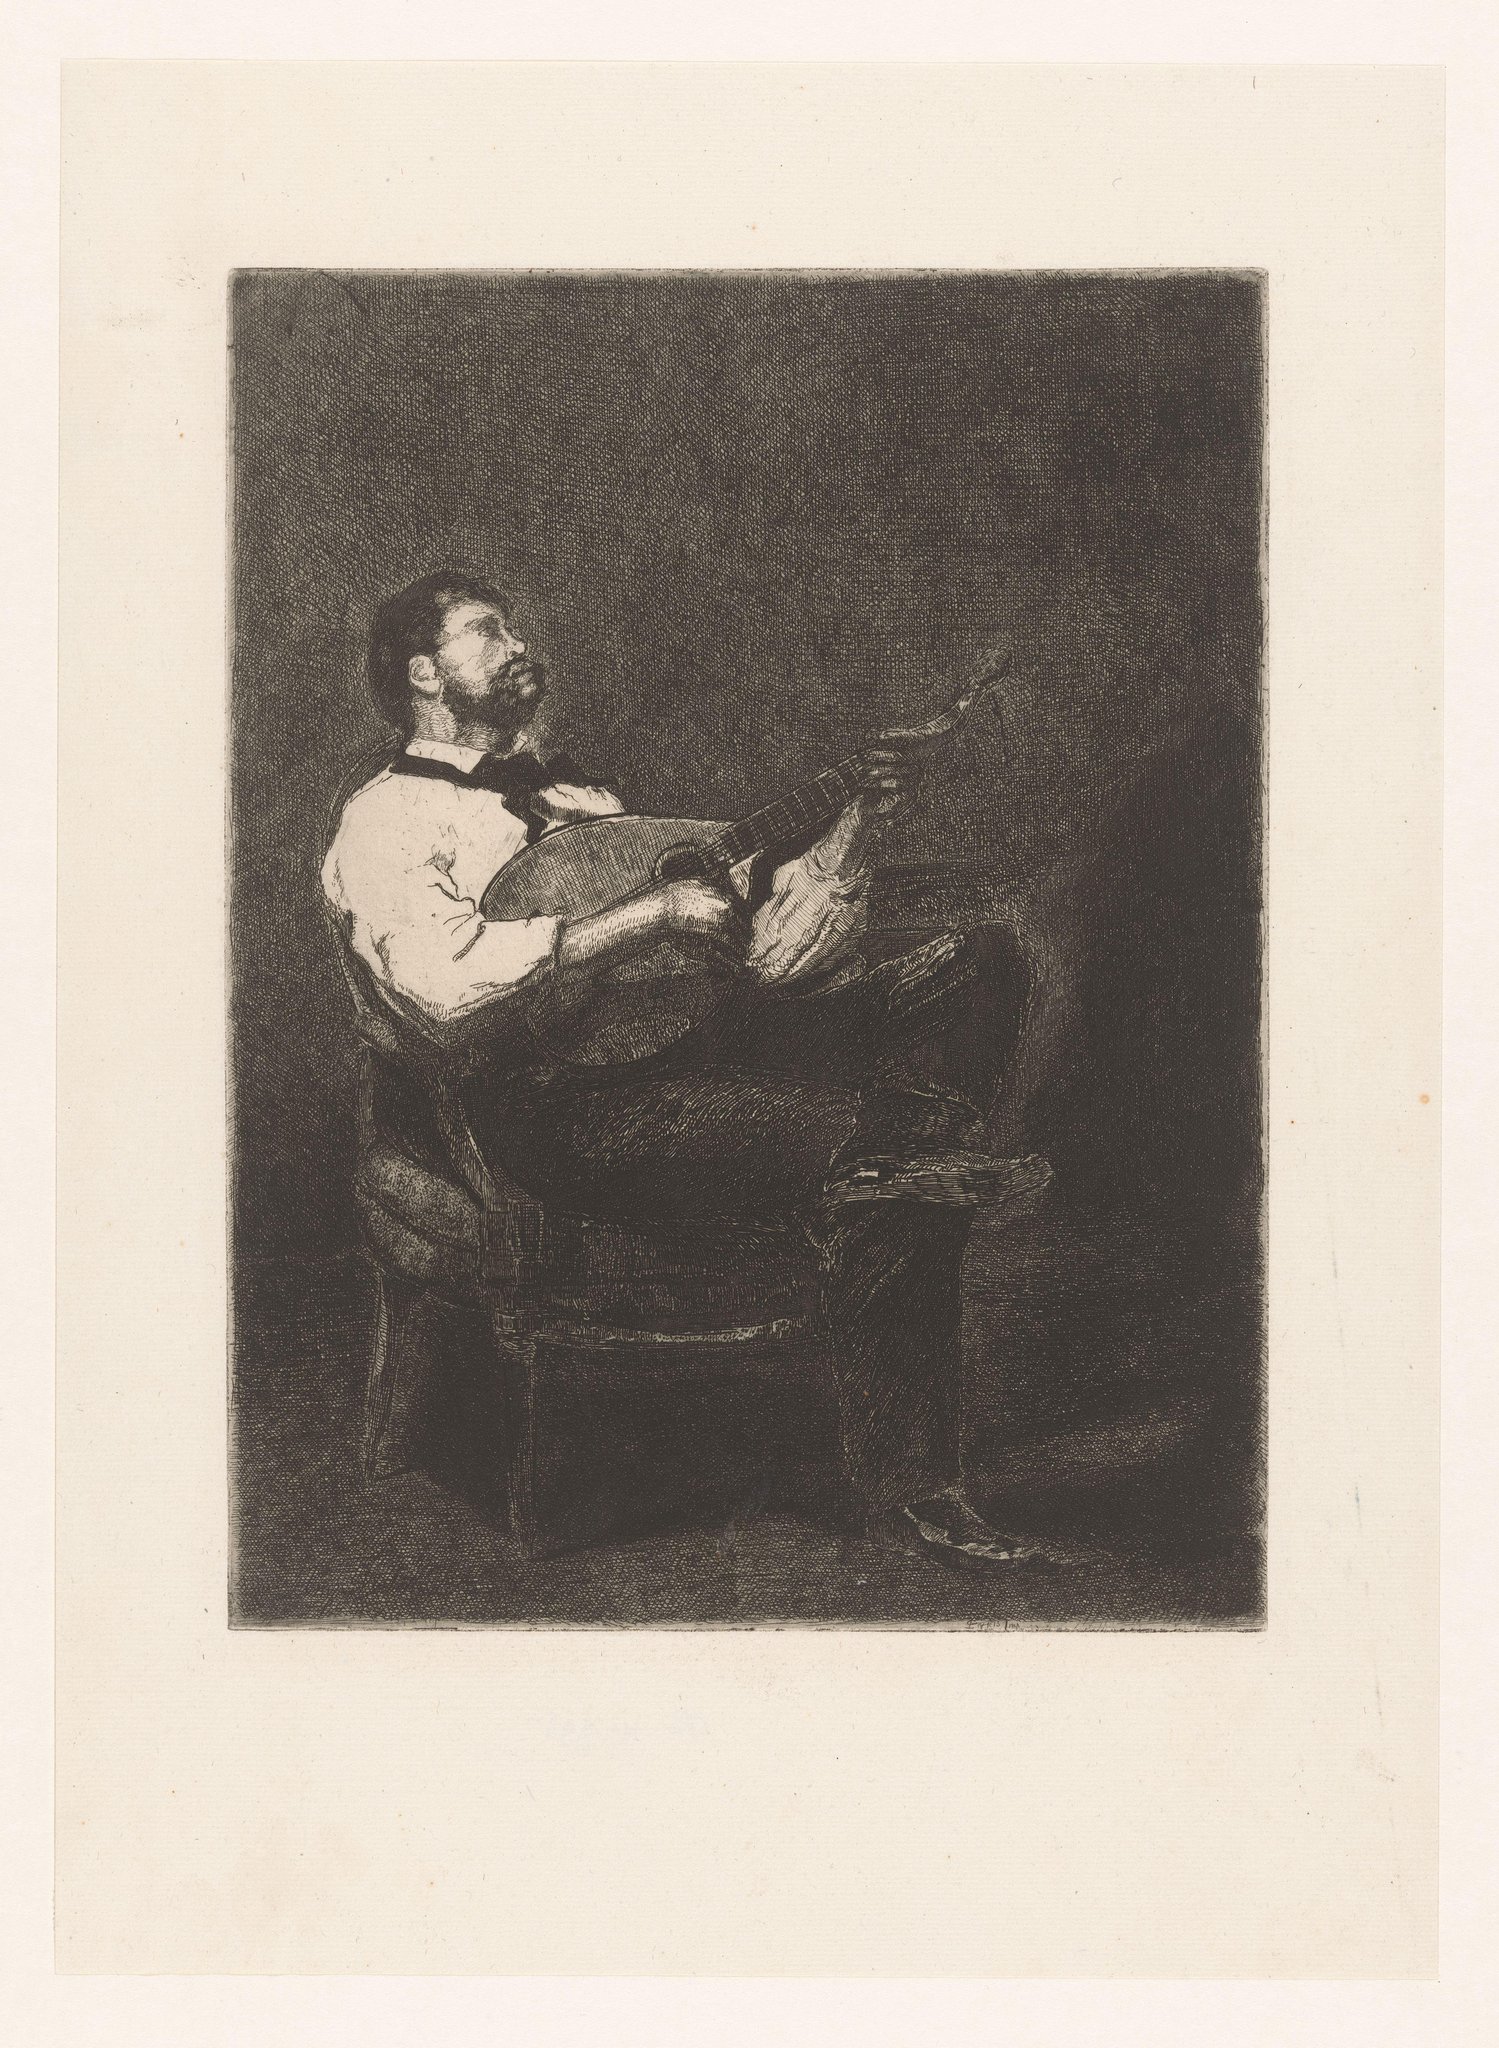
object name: print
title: Gitaarspeler op een stoel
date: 1861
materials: paper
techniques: etching, intaglio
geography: paris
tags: one person playing string instrument (plucked), cithern, mandolin, guitar, balalaika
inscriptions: collector's mark: Lugt 2228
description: Maakt deel uit van een zesdelige serie, getiteld: Six Eaux-fortes, dessinées et gravées par F. Bonvin, Peintre. De eerste staat werd in 1861 door Bonvin uitgegeven in Parijs.